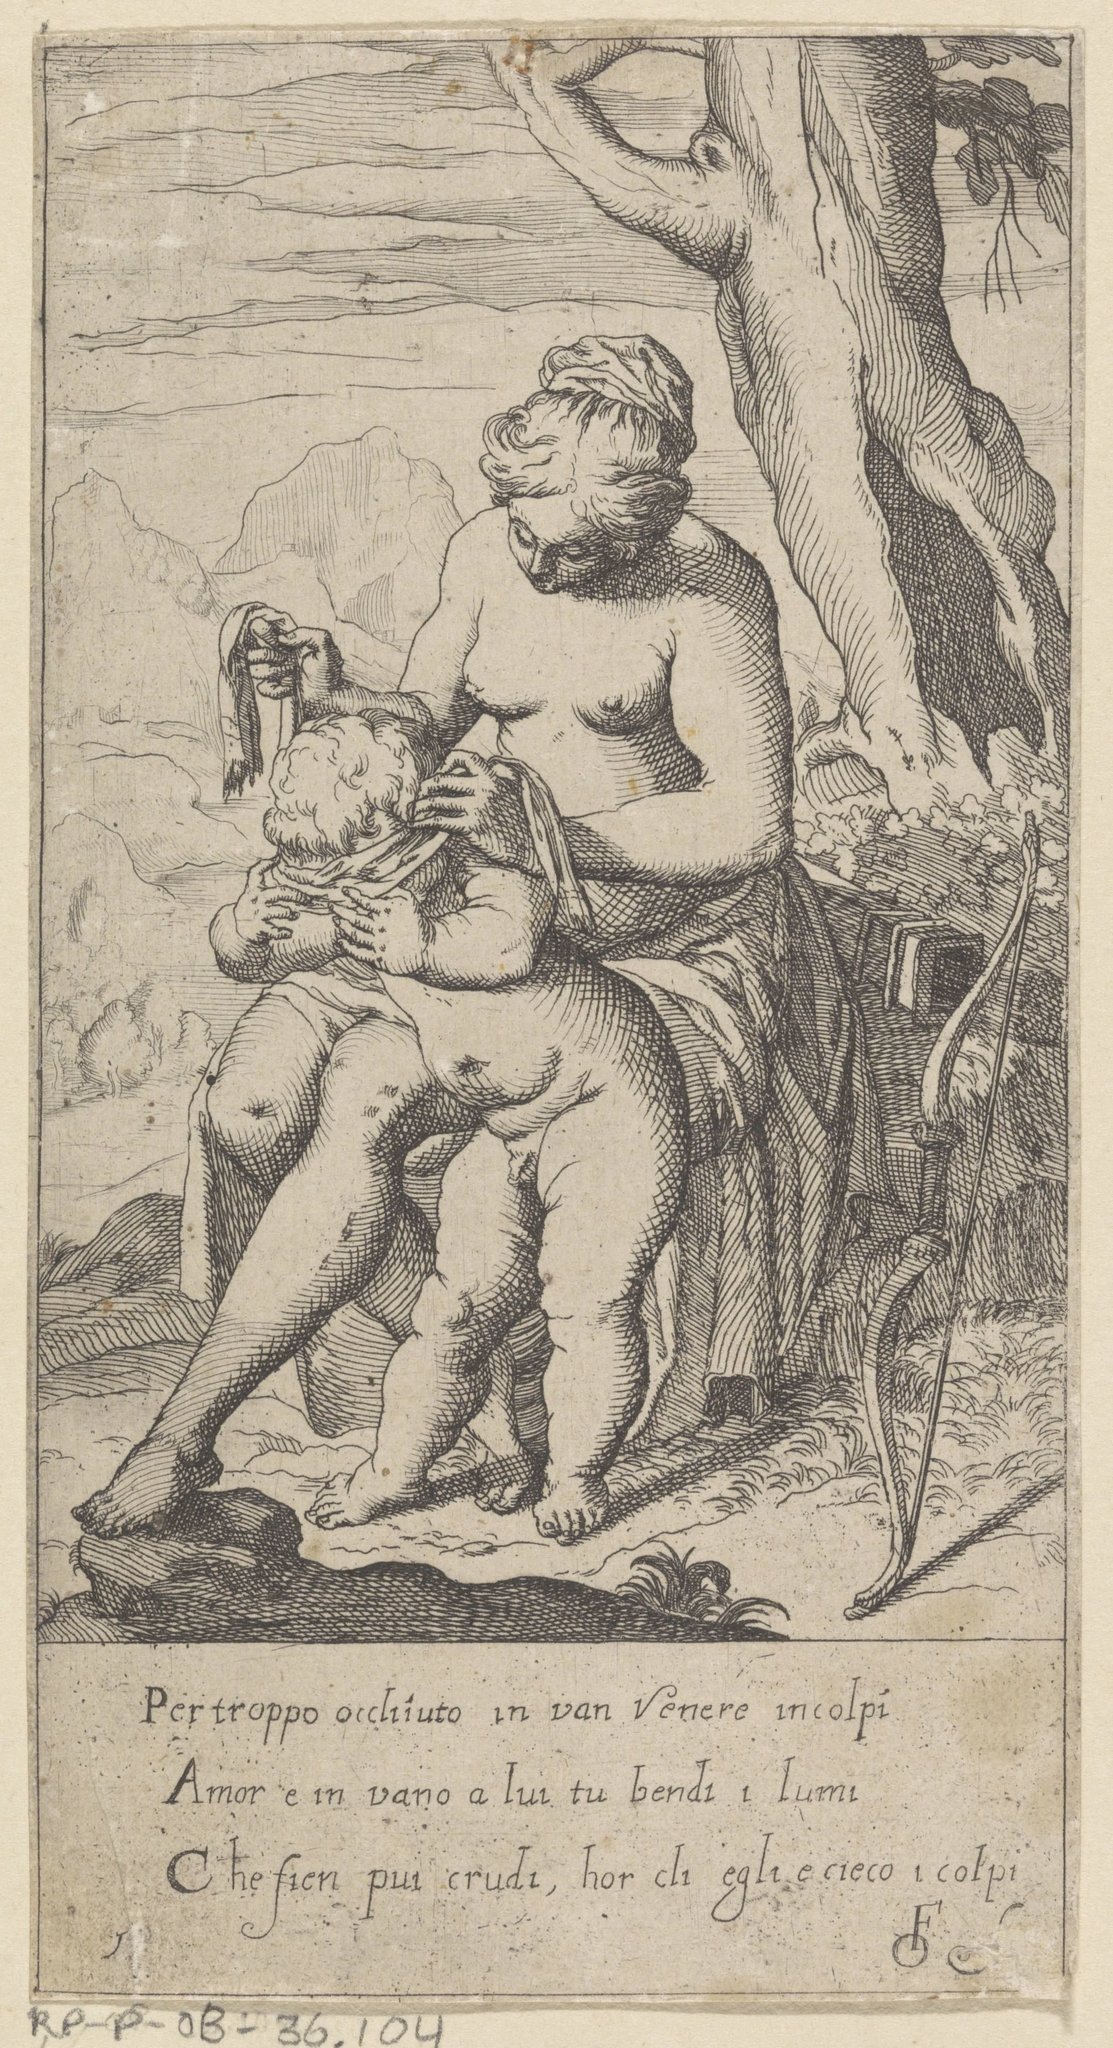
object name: print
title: Scènes met Venus en Amor (kopieën)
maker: Anonymous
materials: paper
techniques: etching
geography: venice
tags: attributes of cupid: blindfold, venus and cupid (cupid not being mere attribute)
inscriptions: collector's mark: Lugt 240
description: Prent uit een reeks van 13 prenten, kopieën naar prenten door Odoardo Fialetti. Alleen de eerste 10 prenten zijn genummerd, plus de tweede titelpagina.